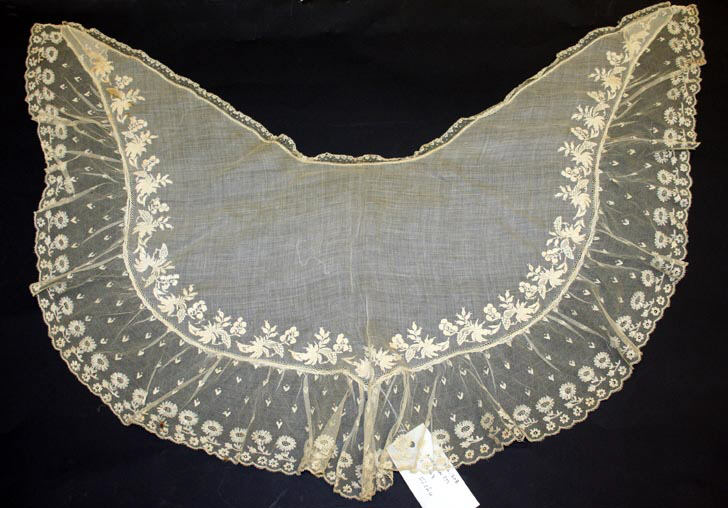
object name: collar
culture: american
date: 1840-1849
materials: cotton